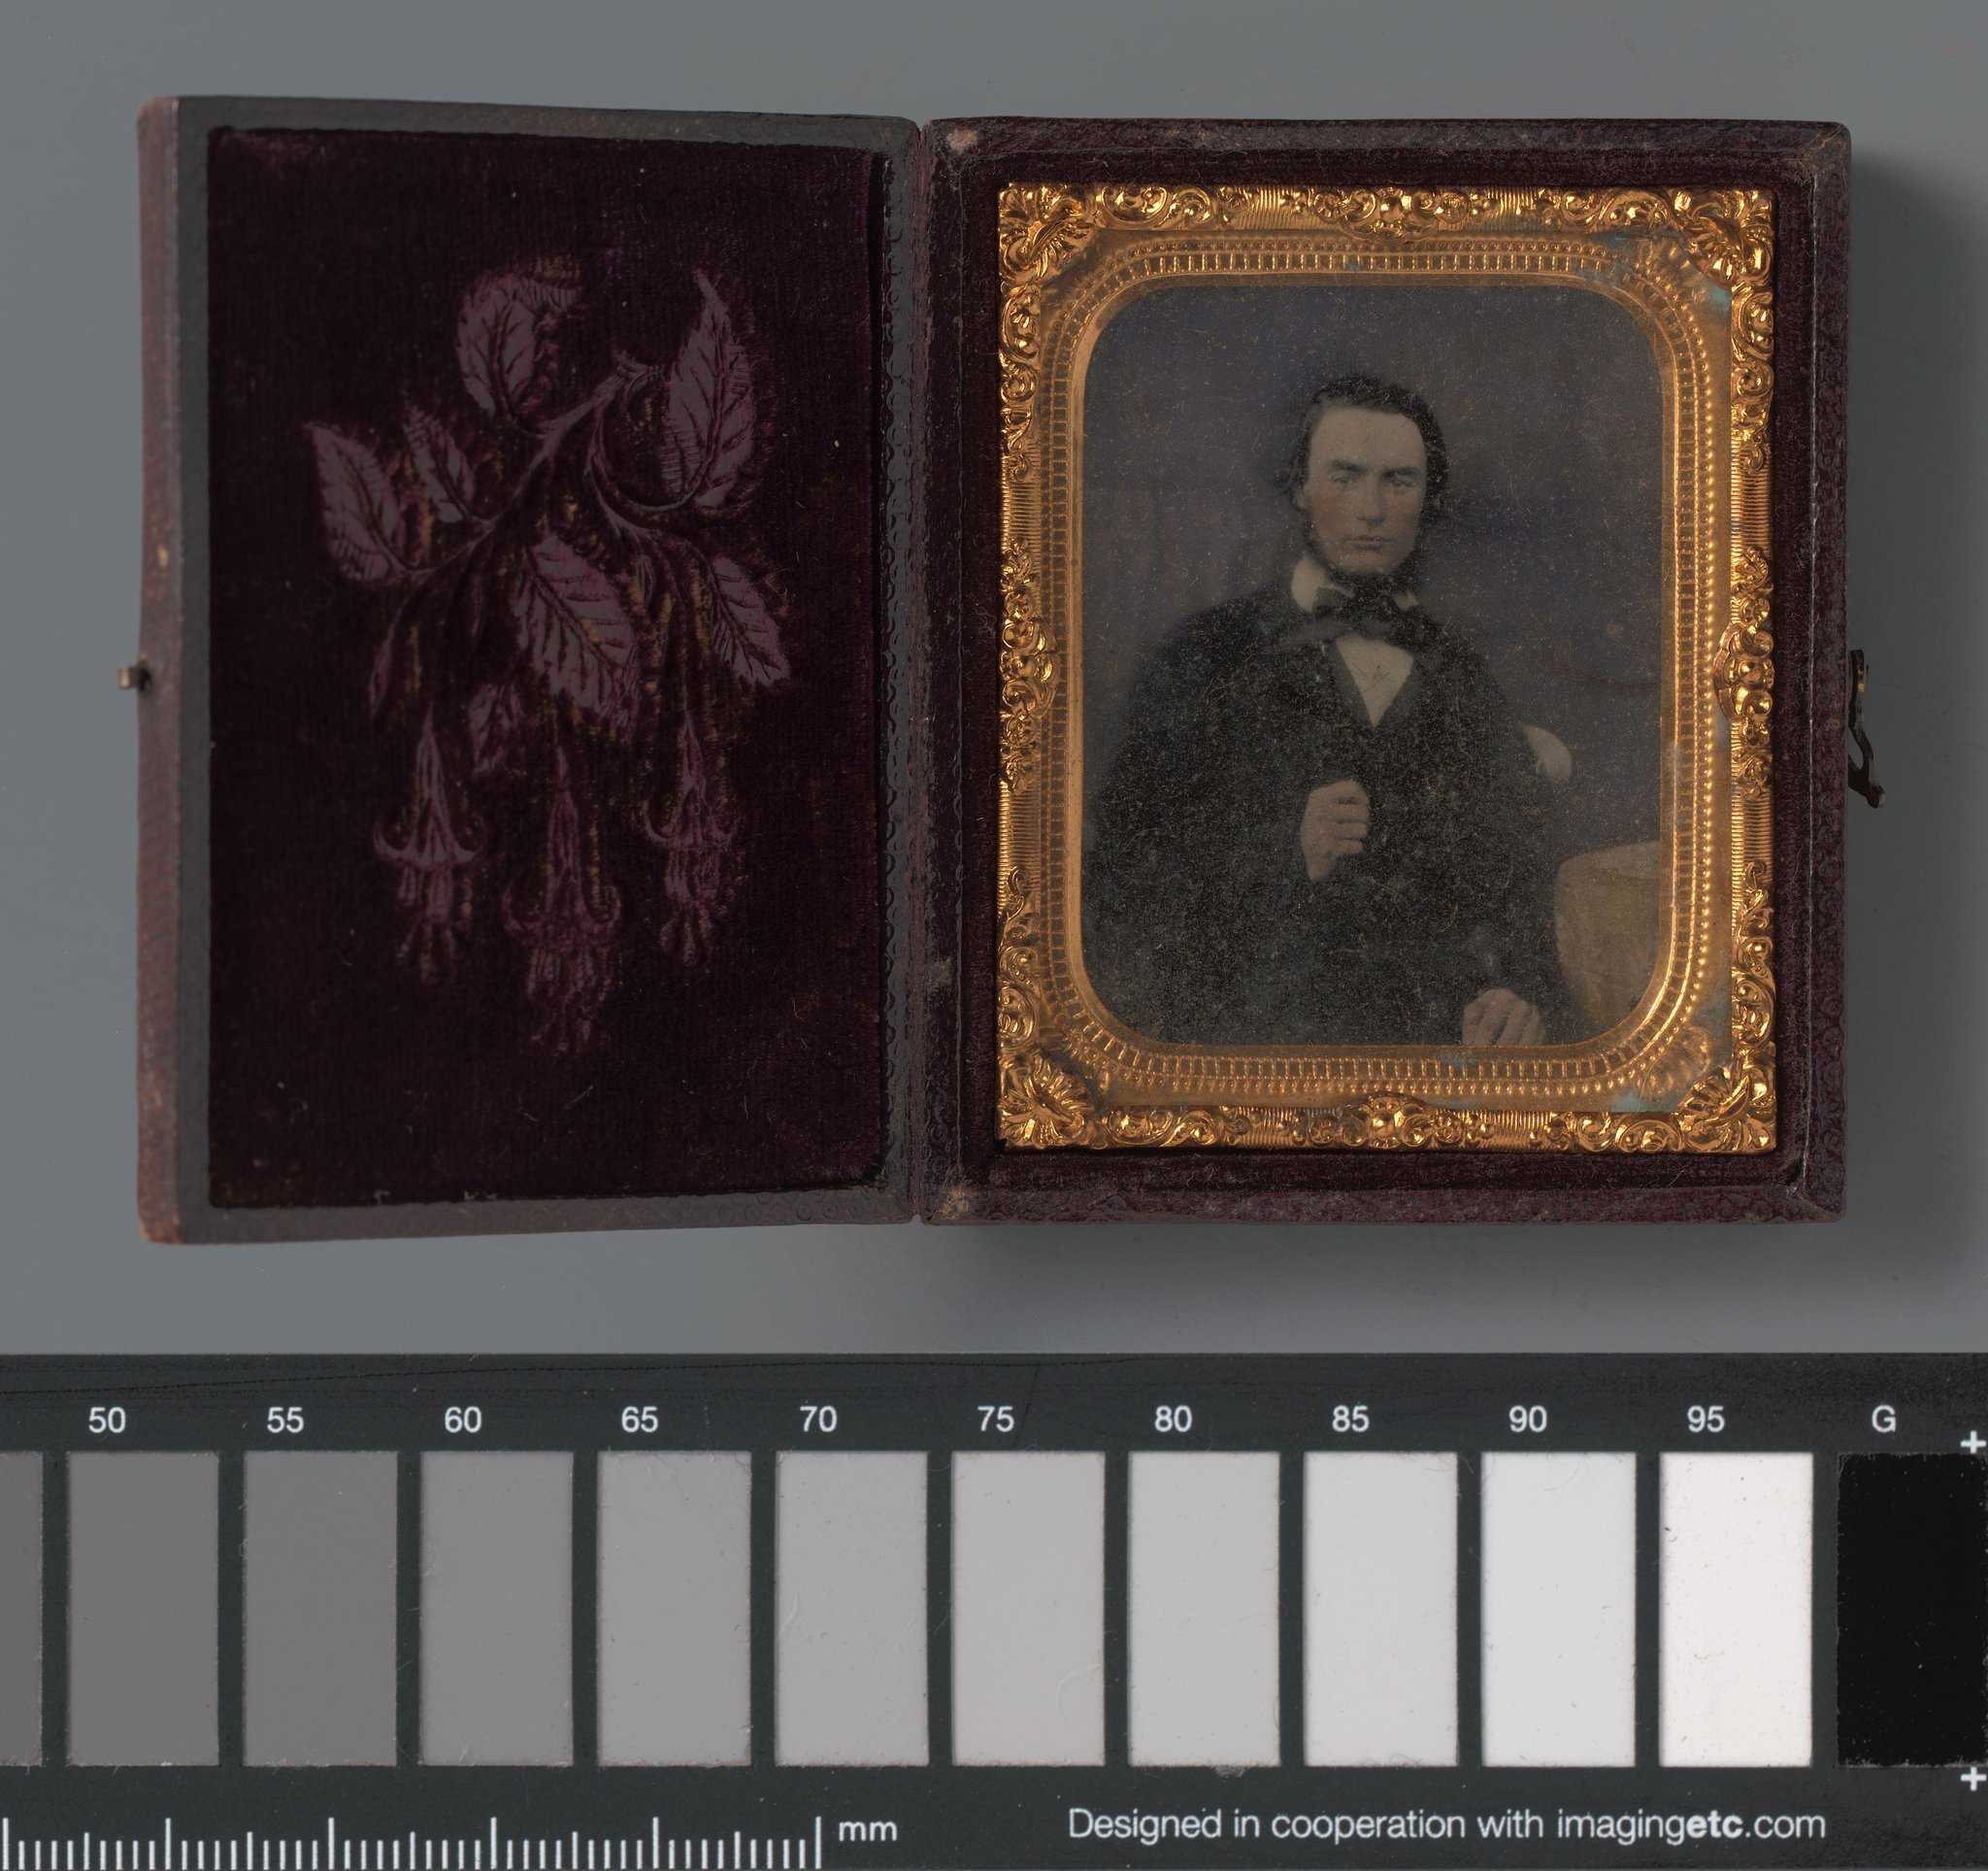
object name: photograph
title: Portret van een onbekende man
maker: Anonymous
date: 1855-1870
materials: glass, leather, metal, velvet, wood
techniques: ambrotype, hand coloring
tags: historical persons